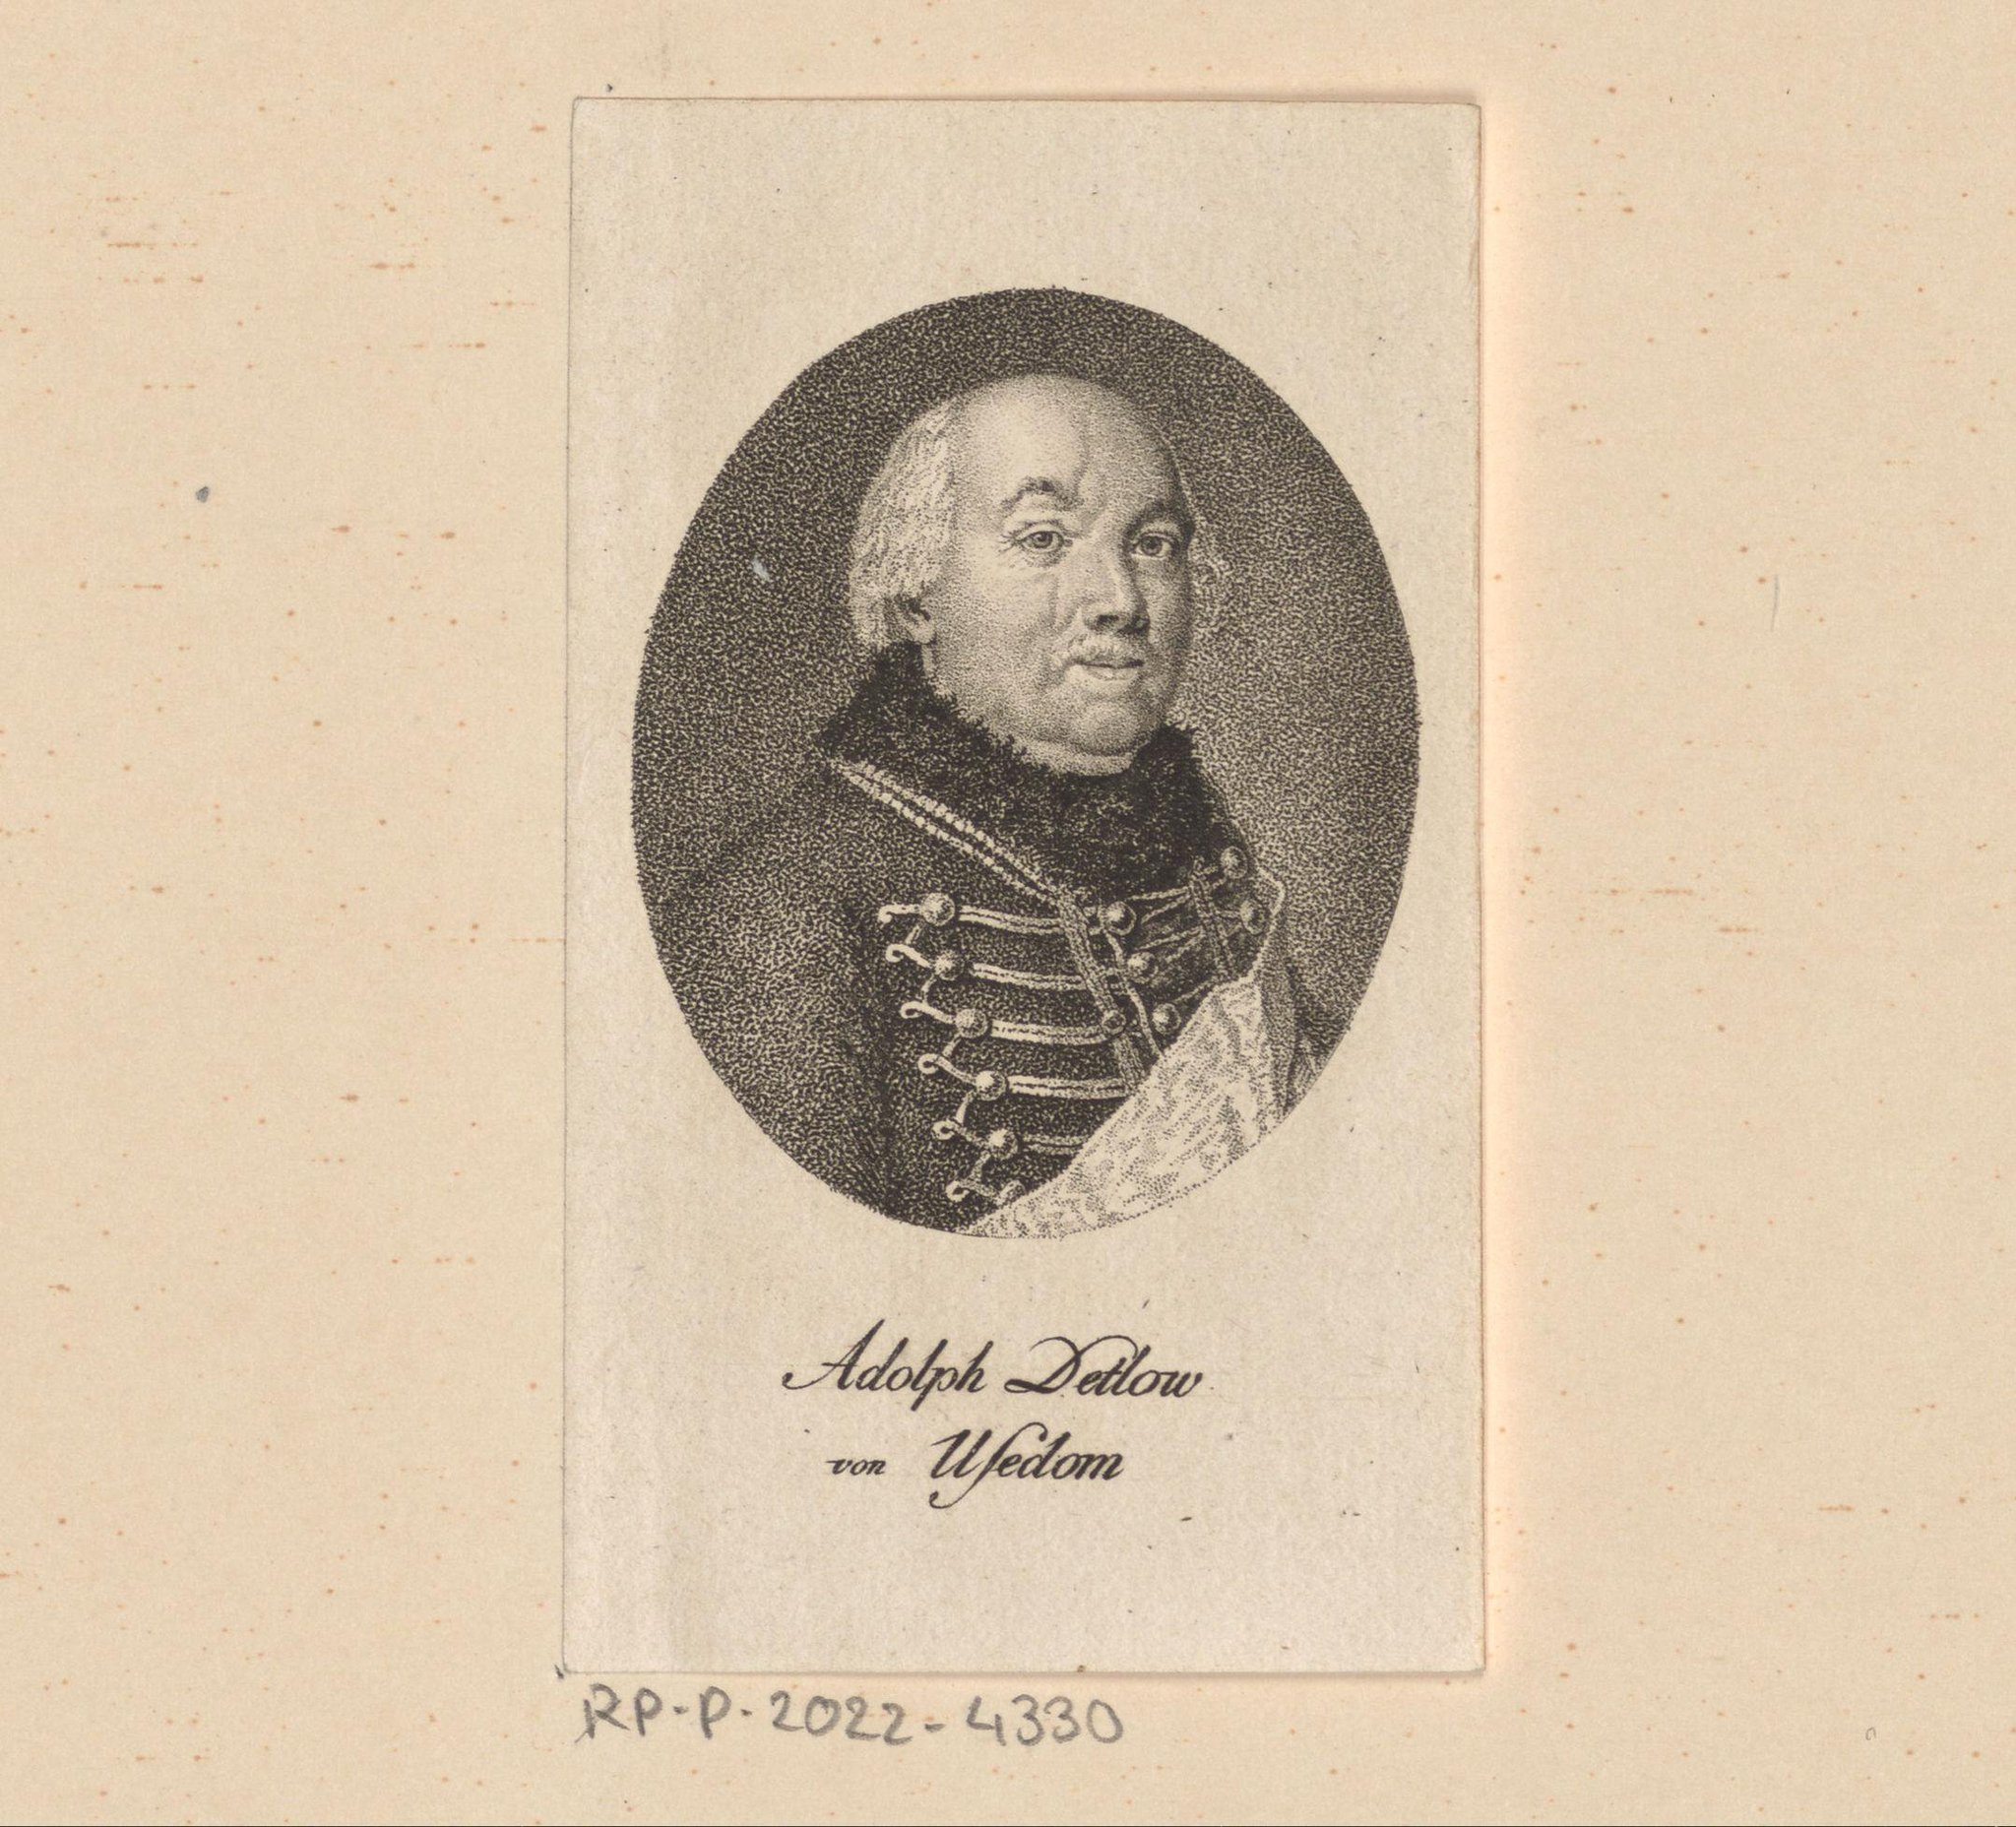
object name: print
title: Portret van Adolph Detlev von Usedom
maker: Anonymous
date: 1746-1800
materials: paper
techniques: etching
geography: germany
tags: poland, commander-in-chief, general, marshal, historical persons